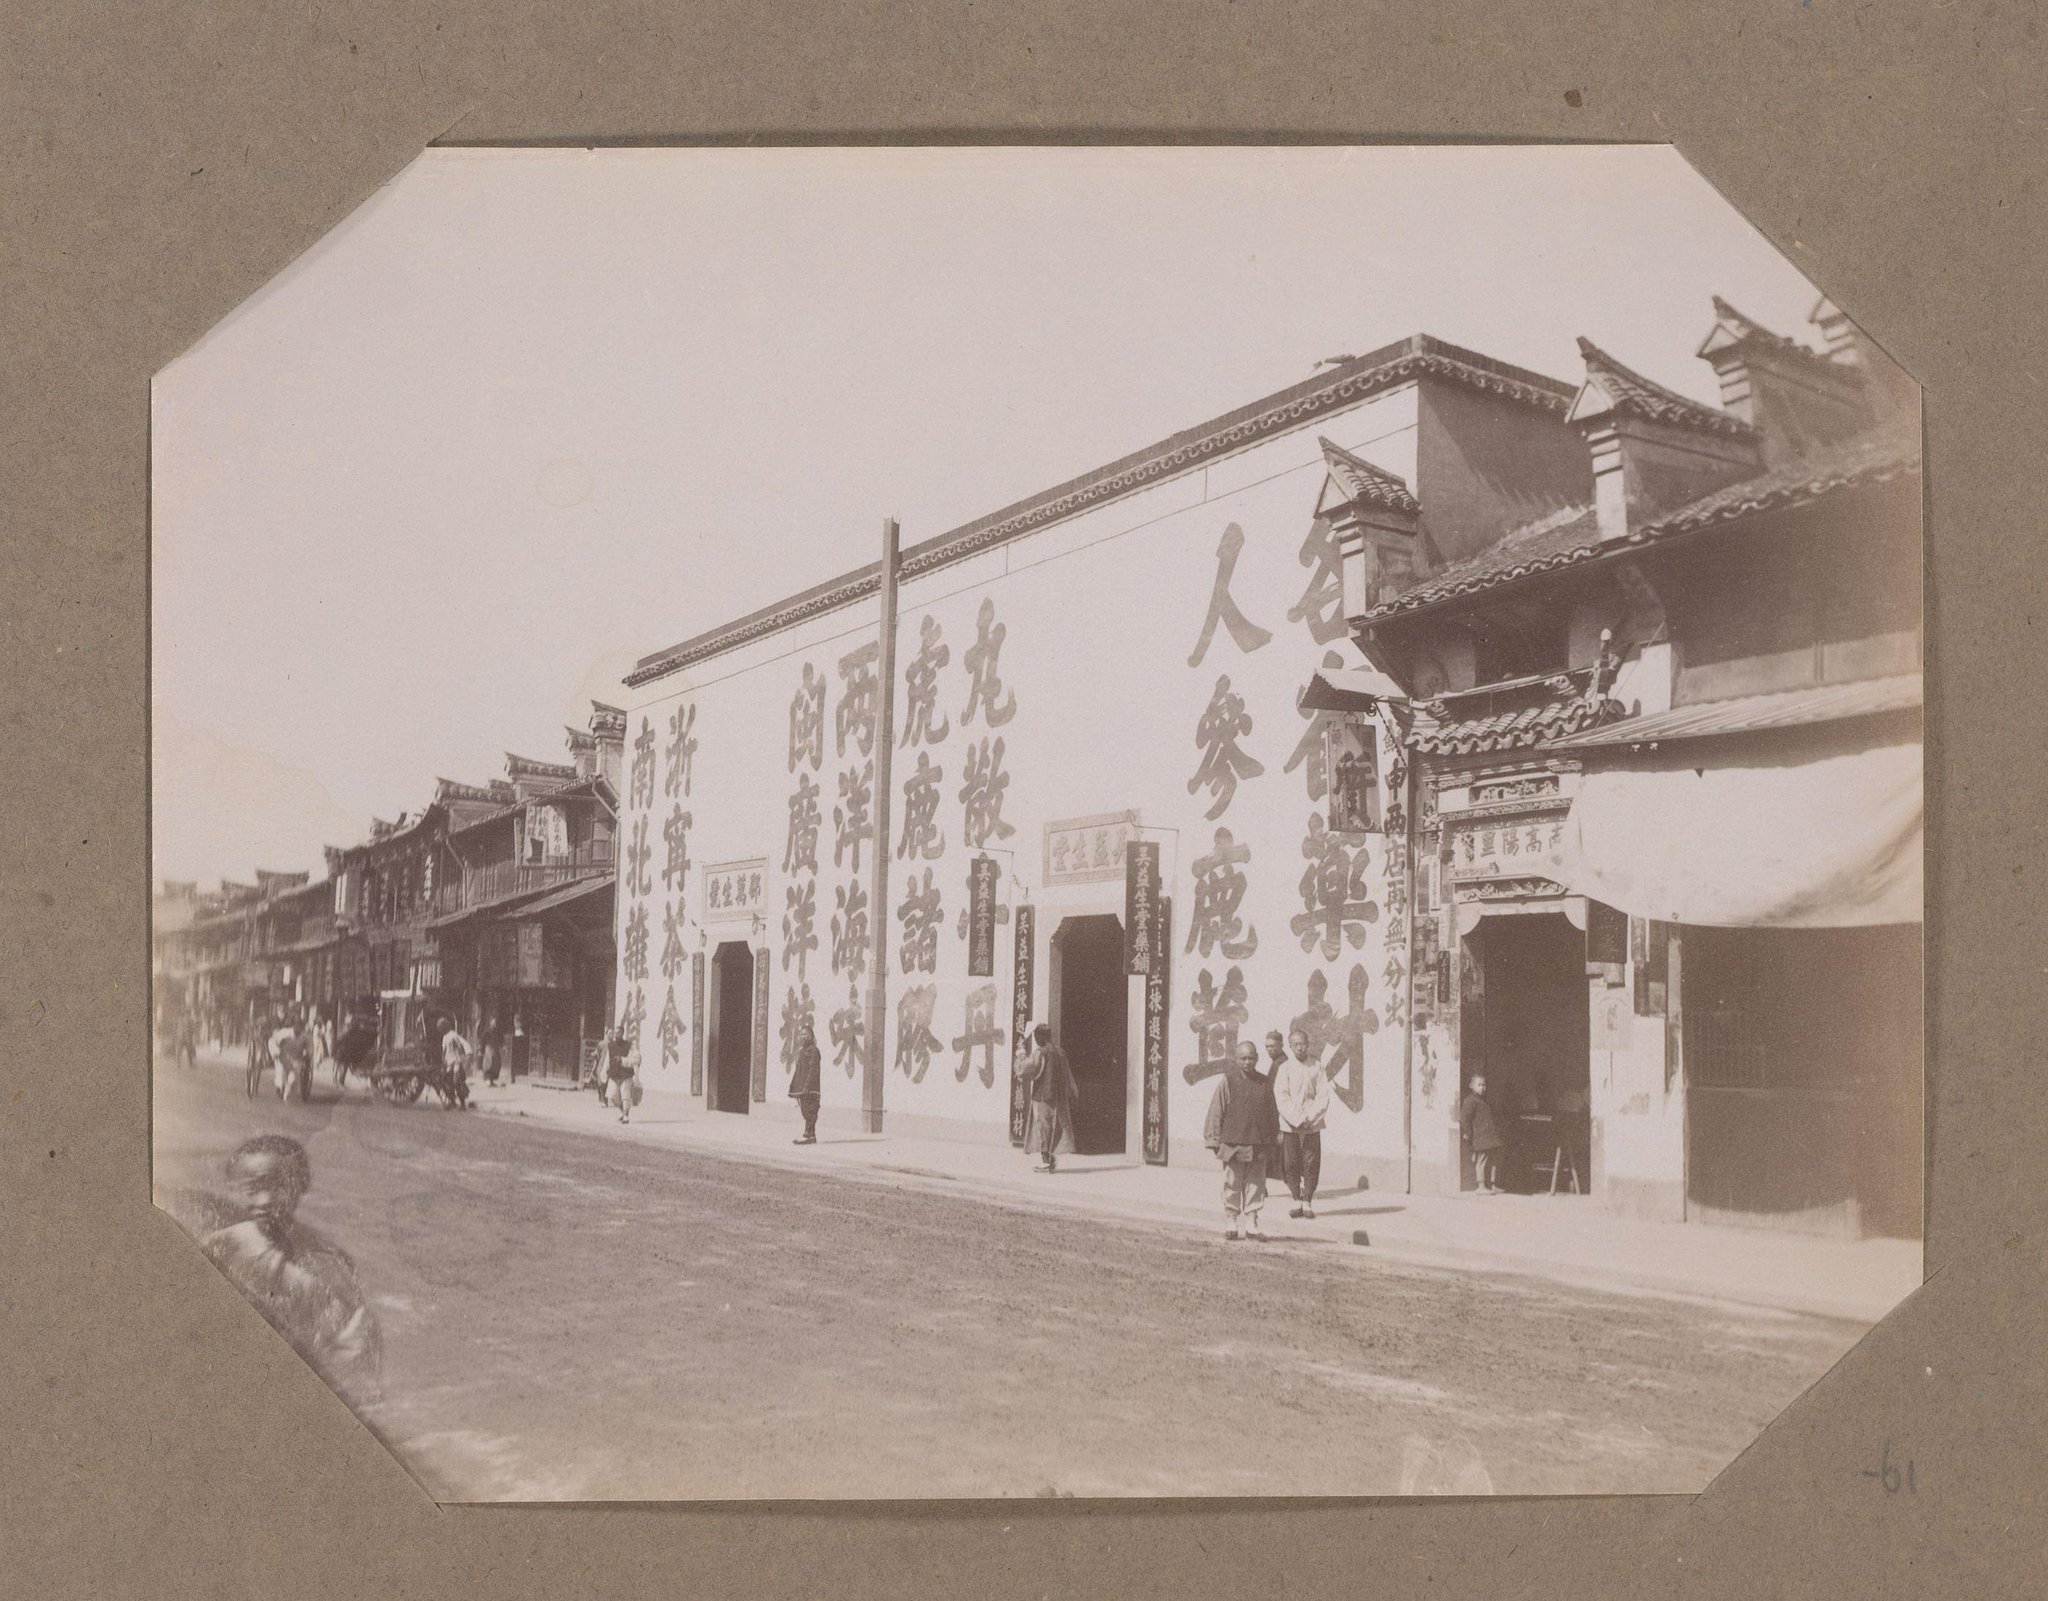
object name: album leaf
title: Gezicht op een straat in China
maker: Anonymous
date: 1890-1903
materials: paper, photographic support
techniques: albumen print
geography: china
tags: façade (of house or building), street (+ city(-scape) with figures, staffage), china